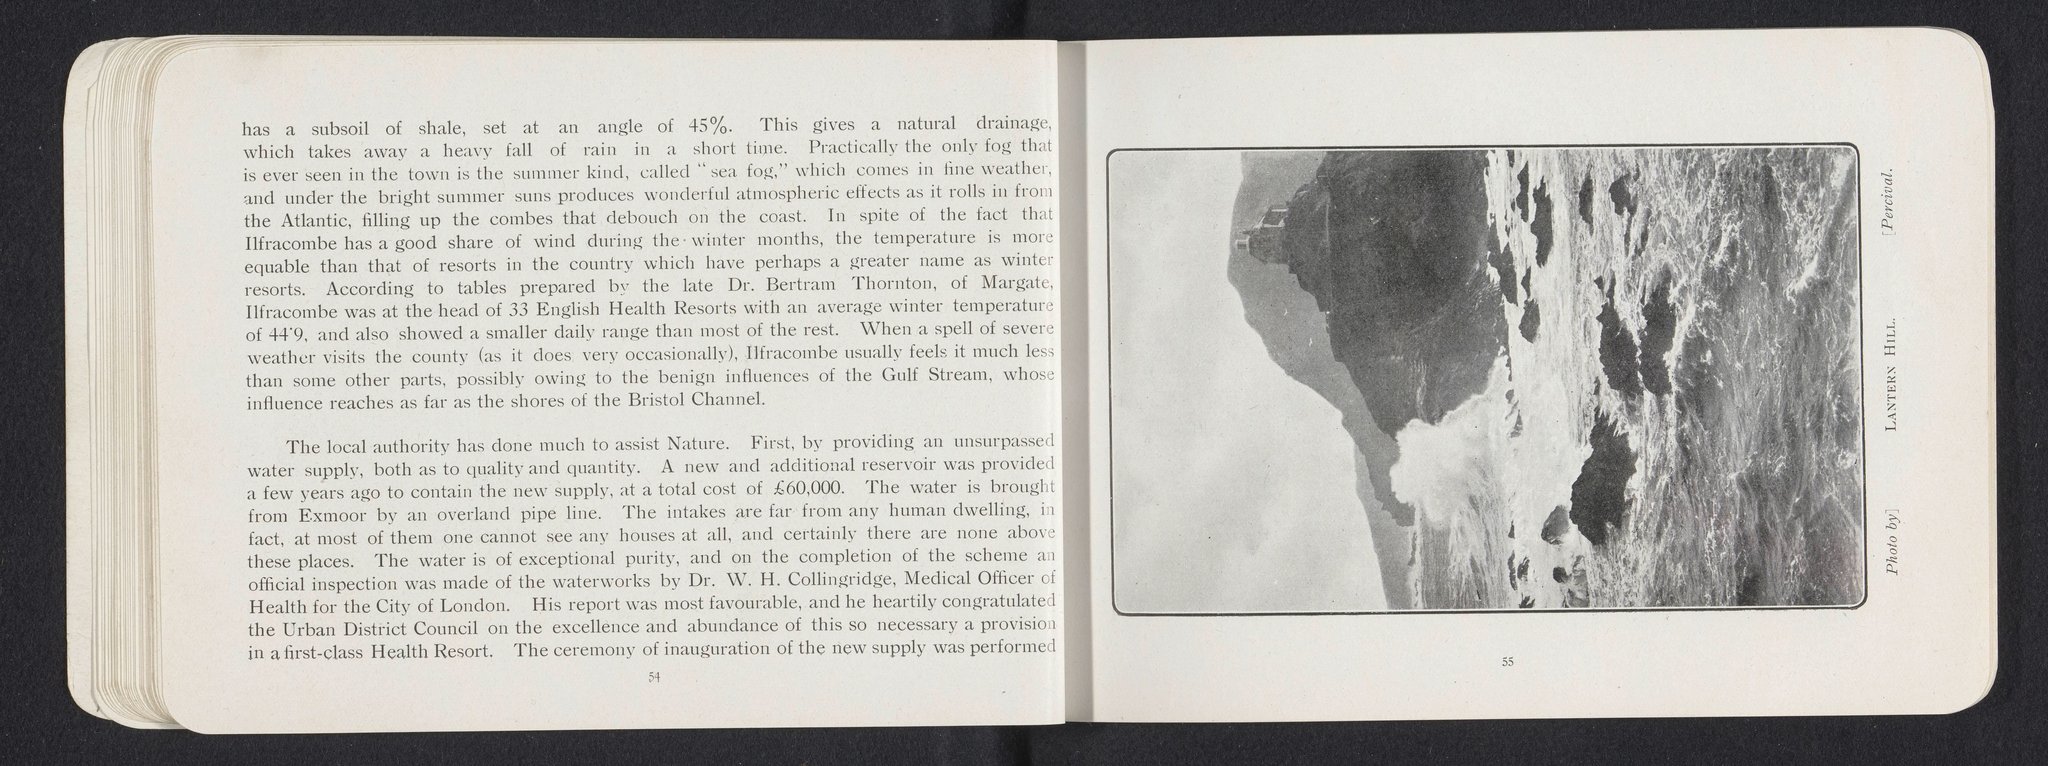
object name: page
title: Lantern Hill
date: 1900-1920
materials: paper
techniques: autotype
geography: devon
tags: rocky coast, sea